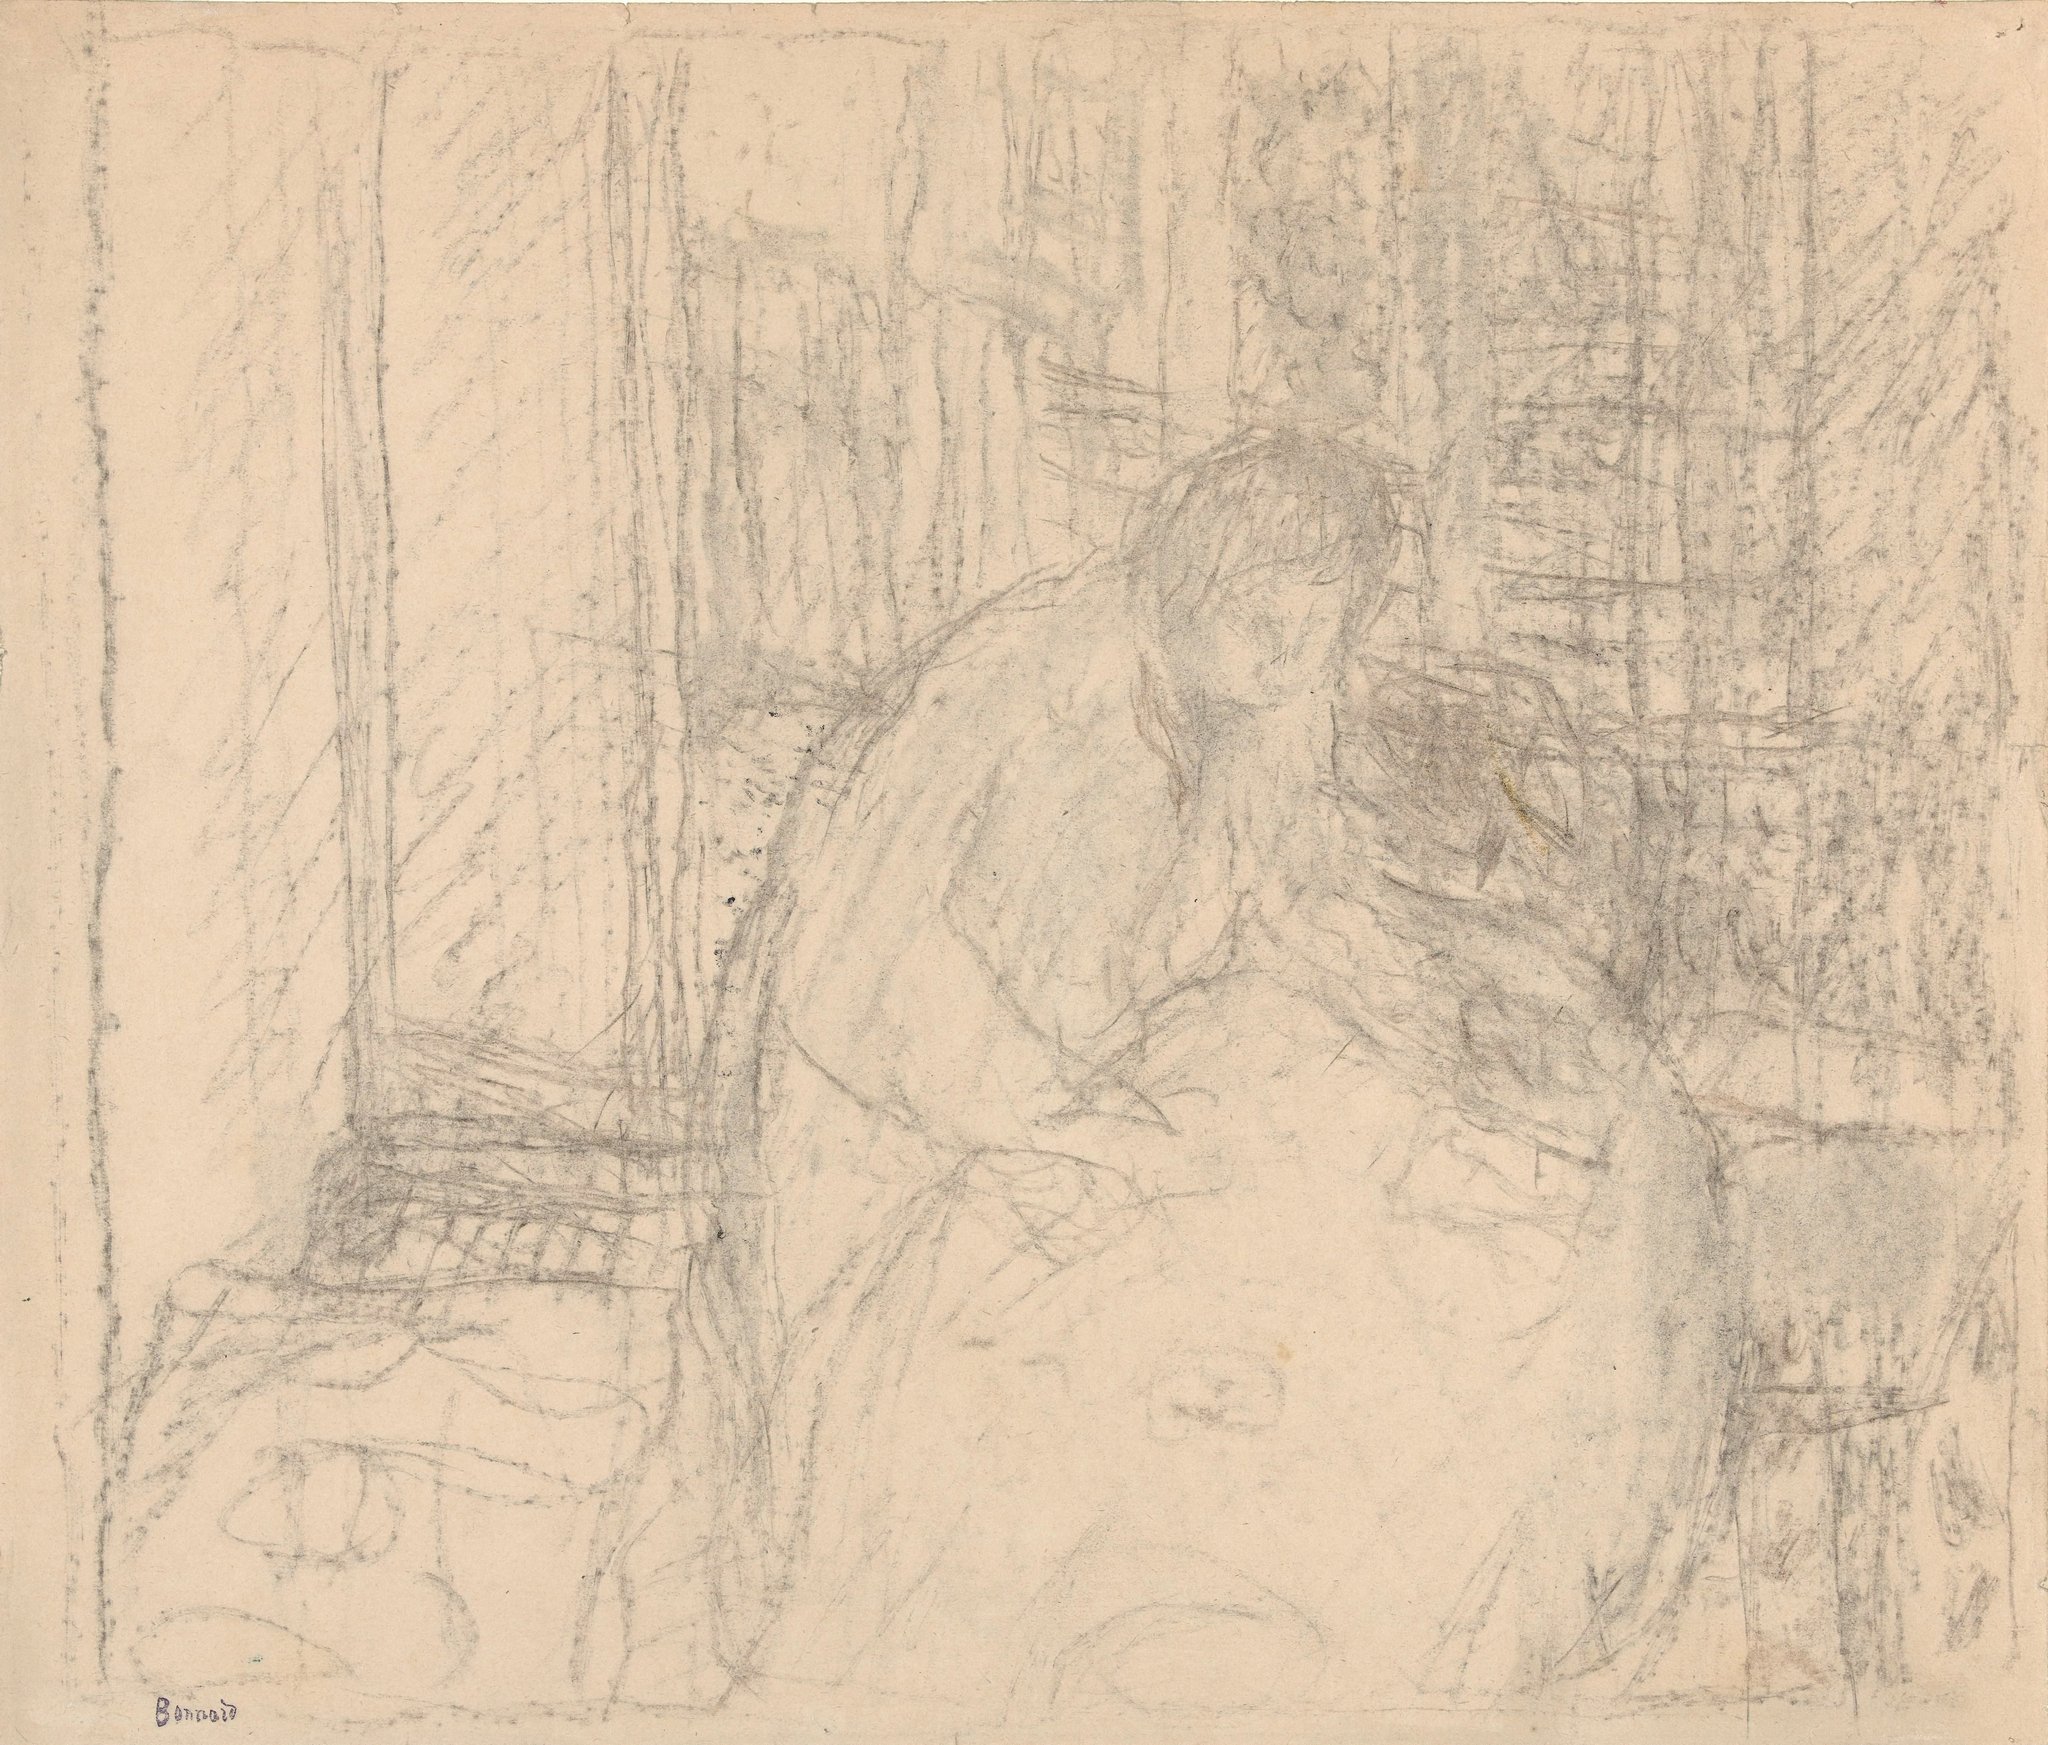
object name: drawing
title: Marthe aan haar ontbijt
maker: pierre bonnard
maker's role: draughtsman, print maker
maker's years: 1867-1947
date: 1877-1947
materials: chalk, charcoal, paper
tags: breakfast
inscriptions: inscription: ‘Marthe au déjeuner’